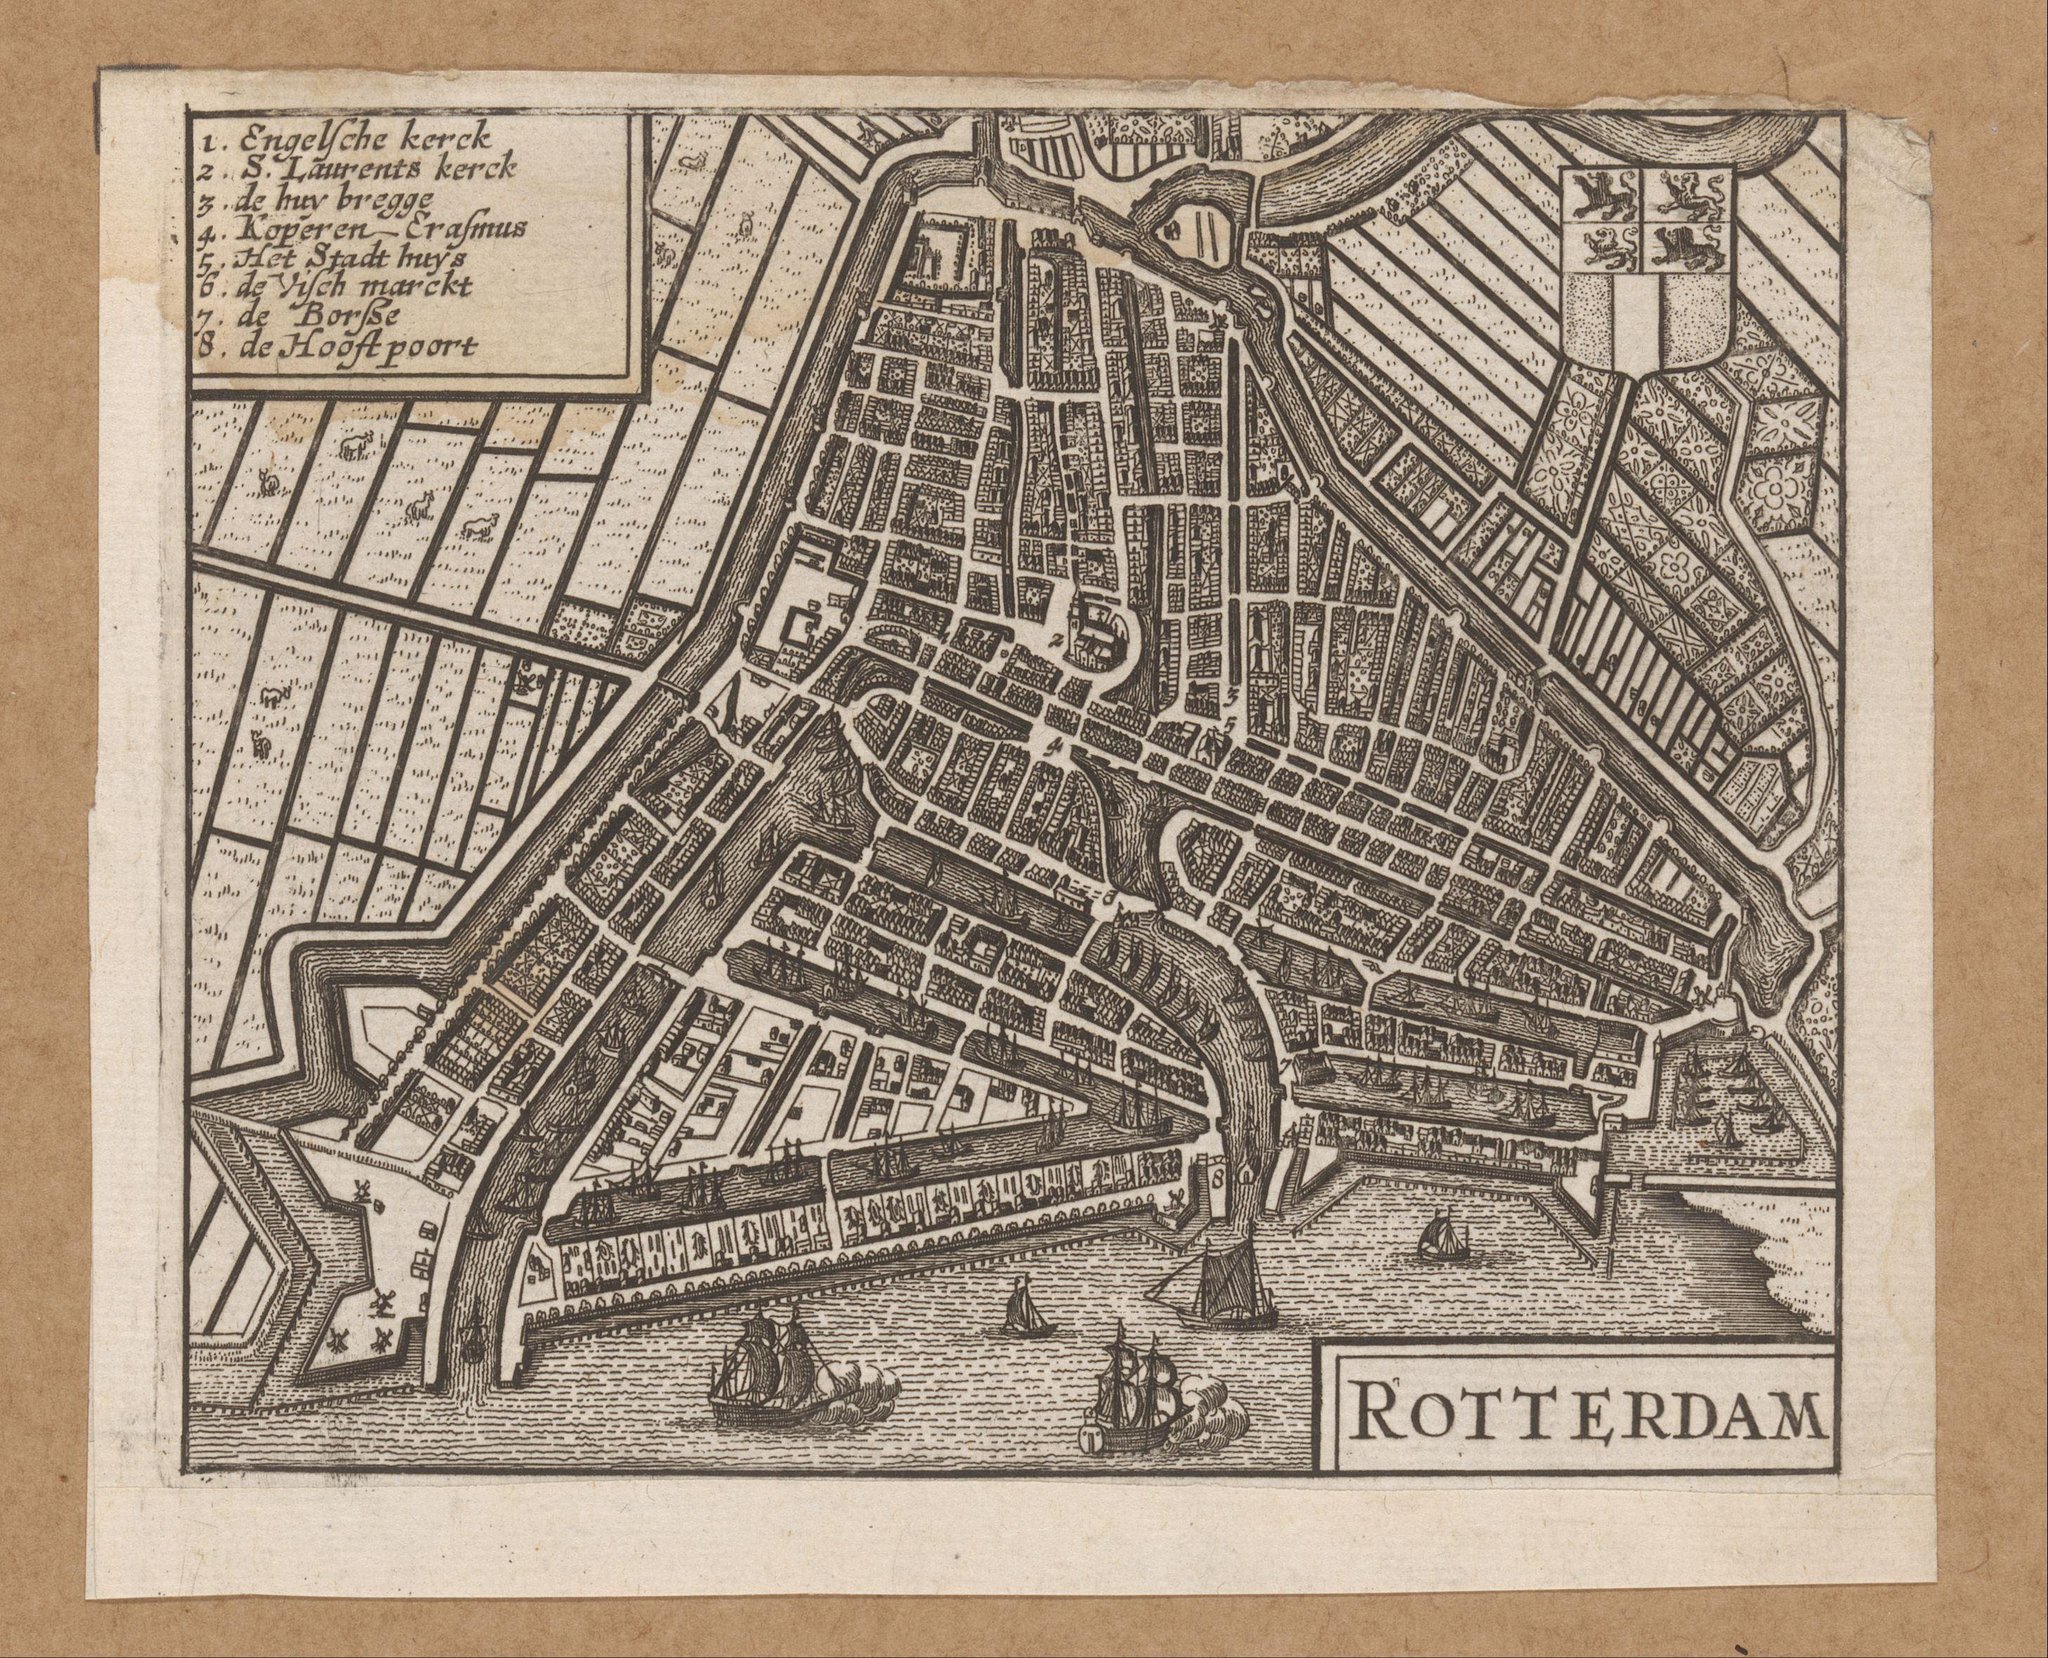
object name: area plan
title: Plattegrond van Rotterdam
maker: Anonymous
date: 1650-1700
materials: paper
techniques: engraving, etching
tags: maps of cities, rotterdam